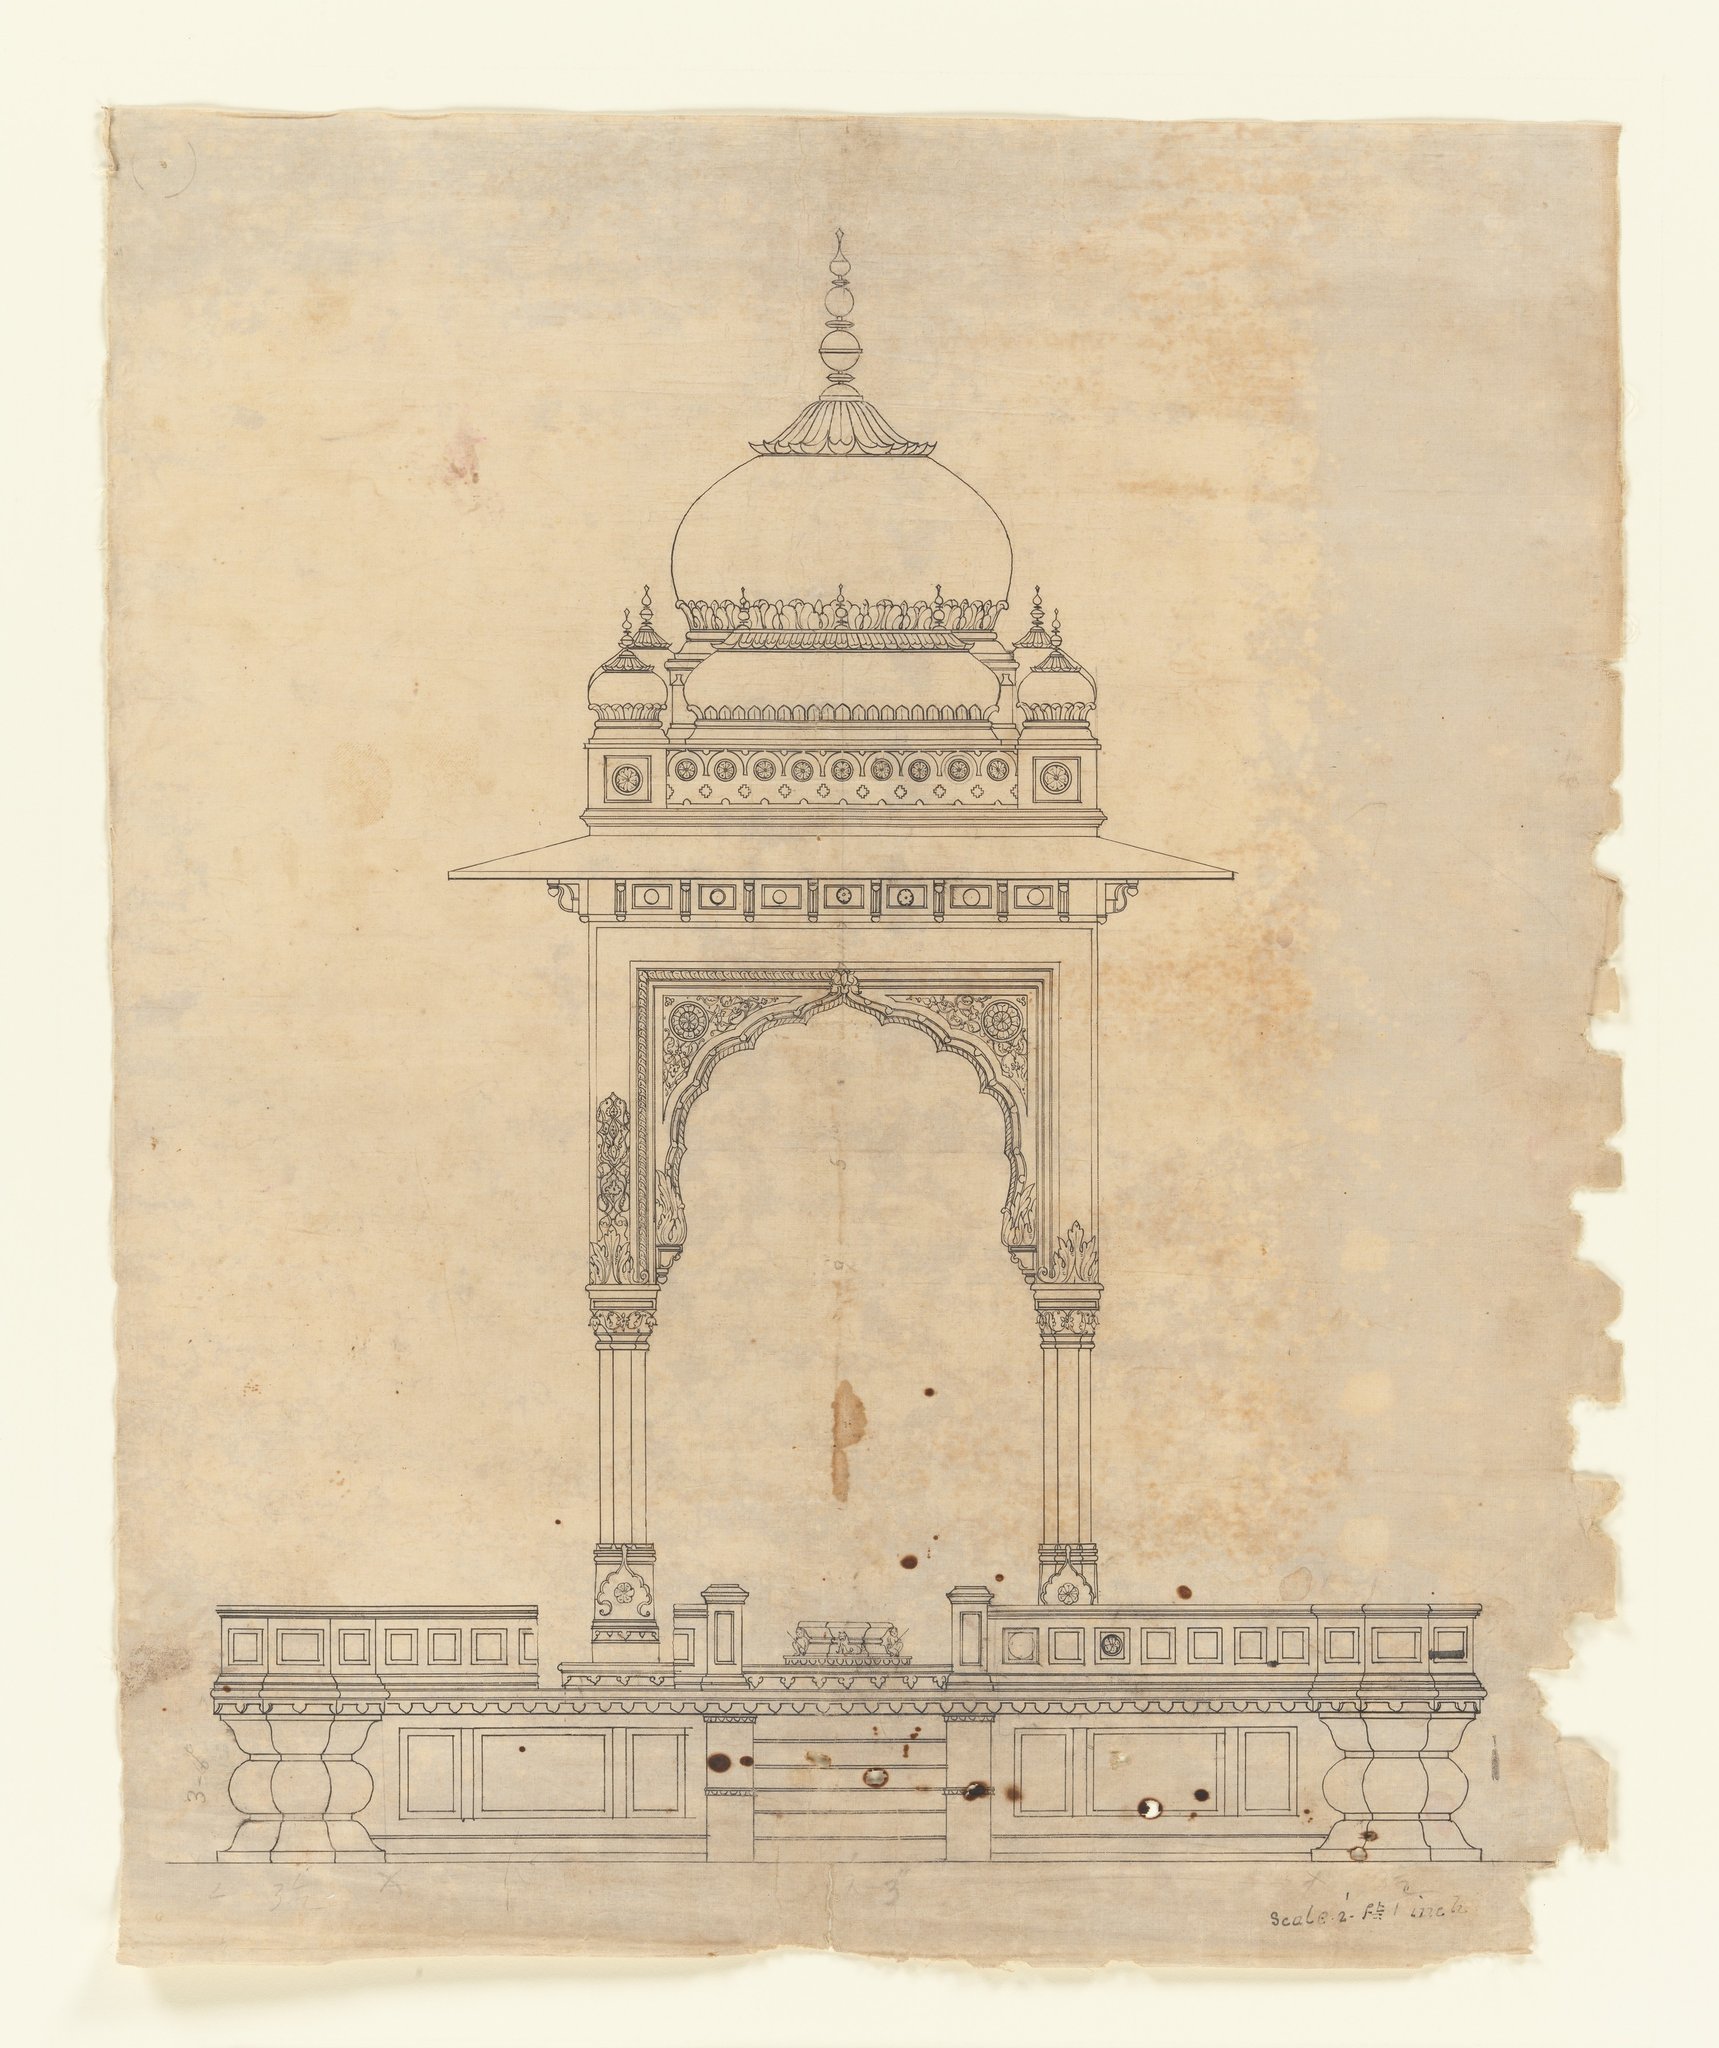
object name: drawing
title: Domed Pavilion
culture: indian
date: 1830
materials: ink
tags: architecture